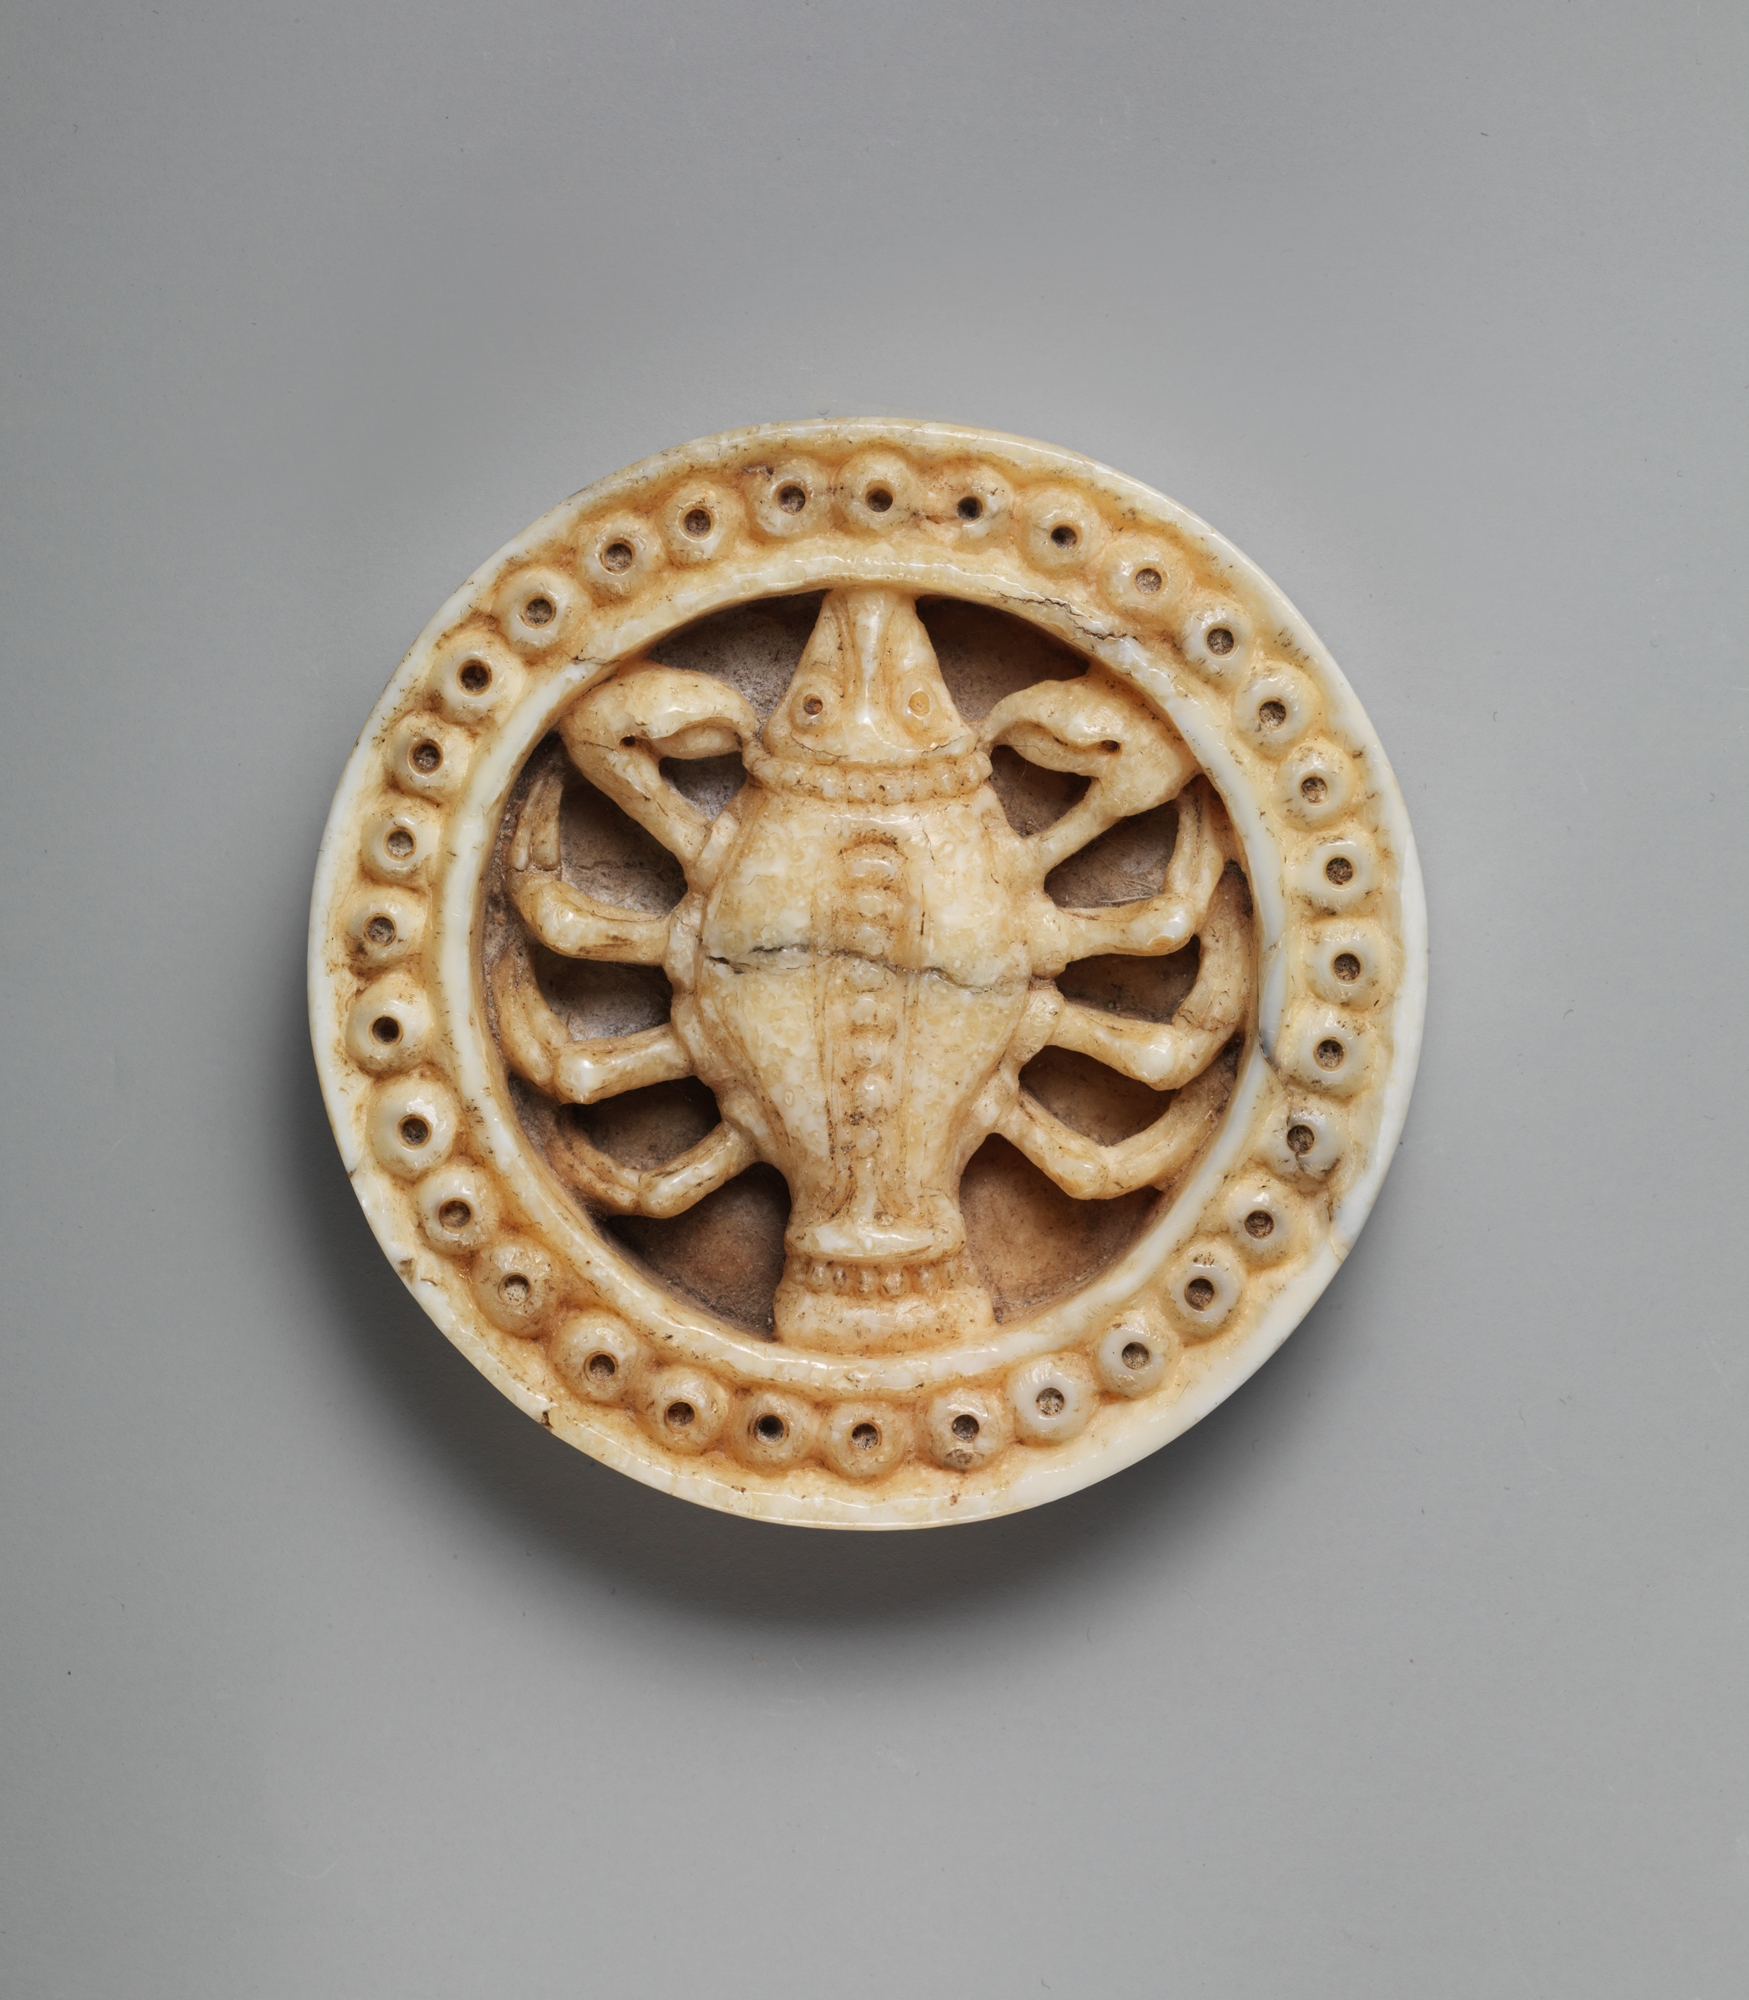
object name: game piece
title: Game Piece with Zodiac Sign of Cancer or Scorpio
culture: french, north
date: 1134-1166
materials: ivory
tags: crabs,zodiac,games